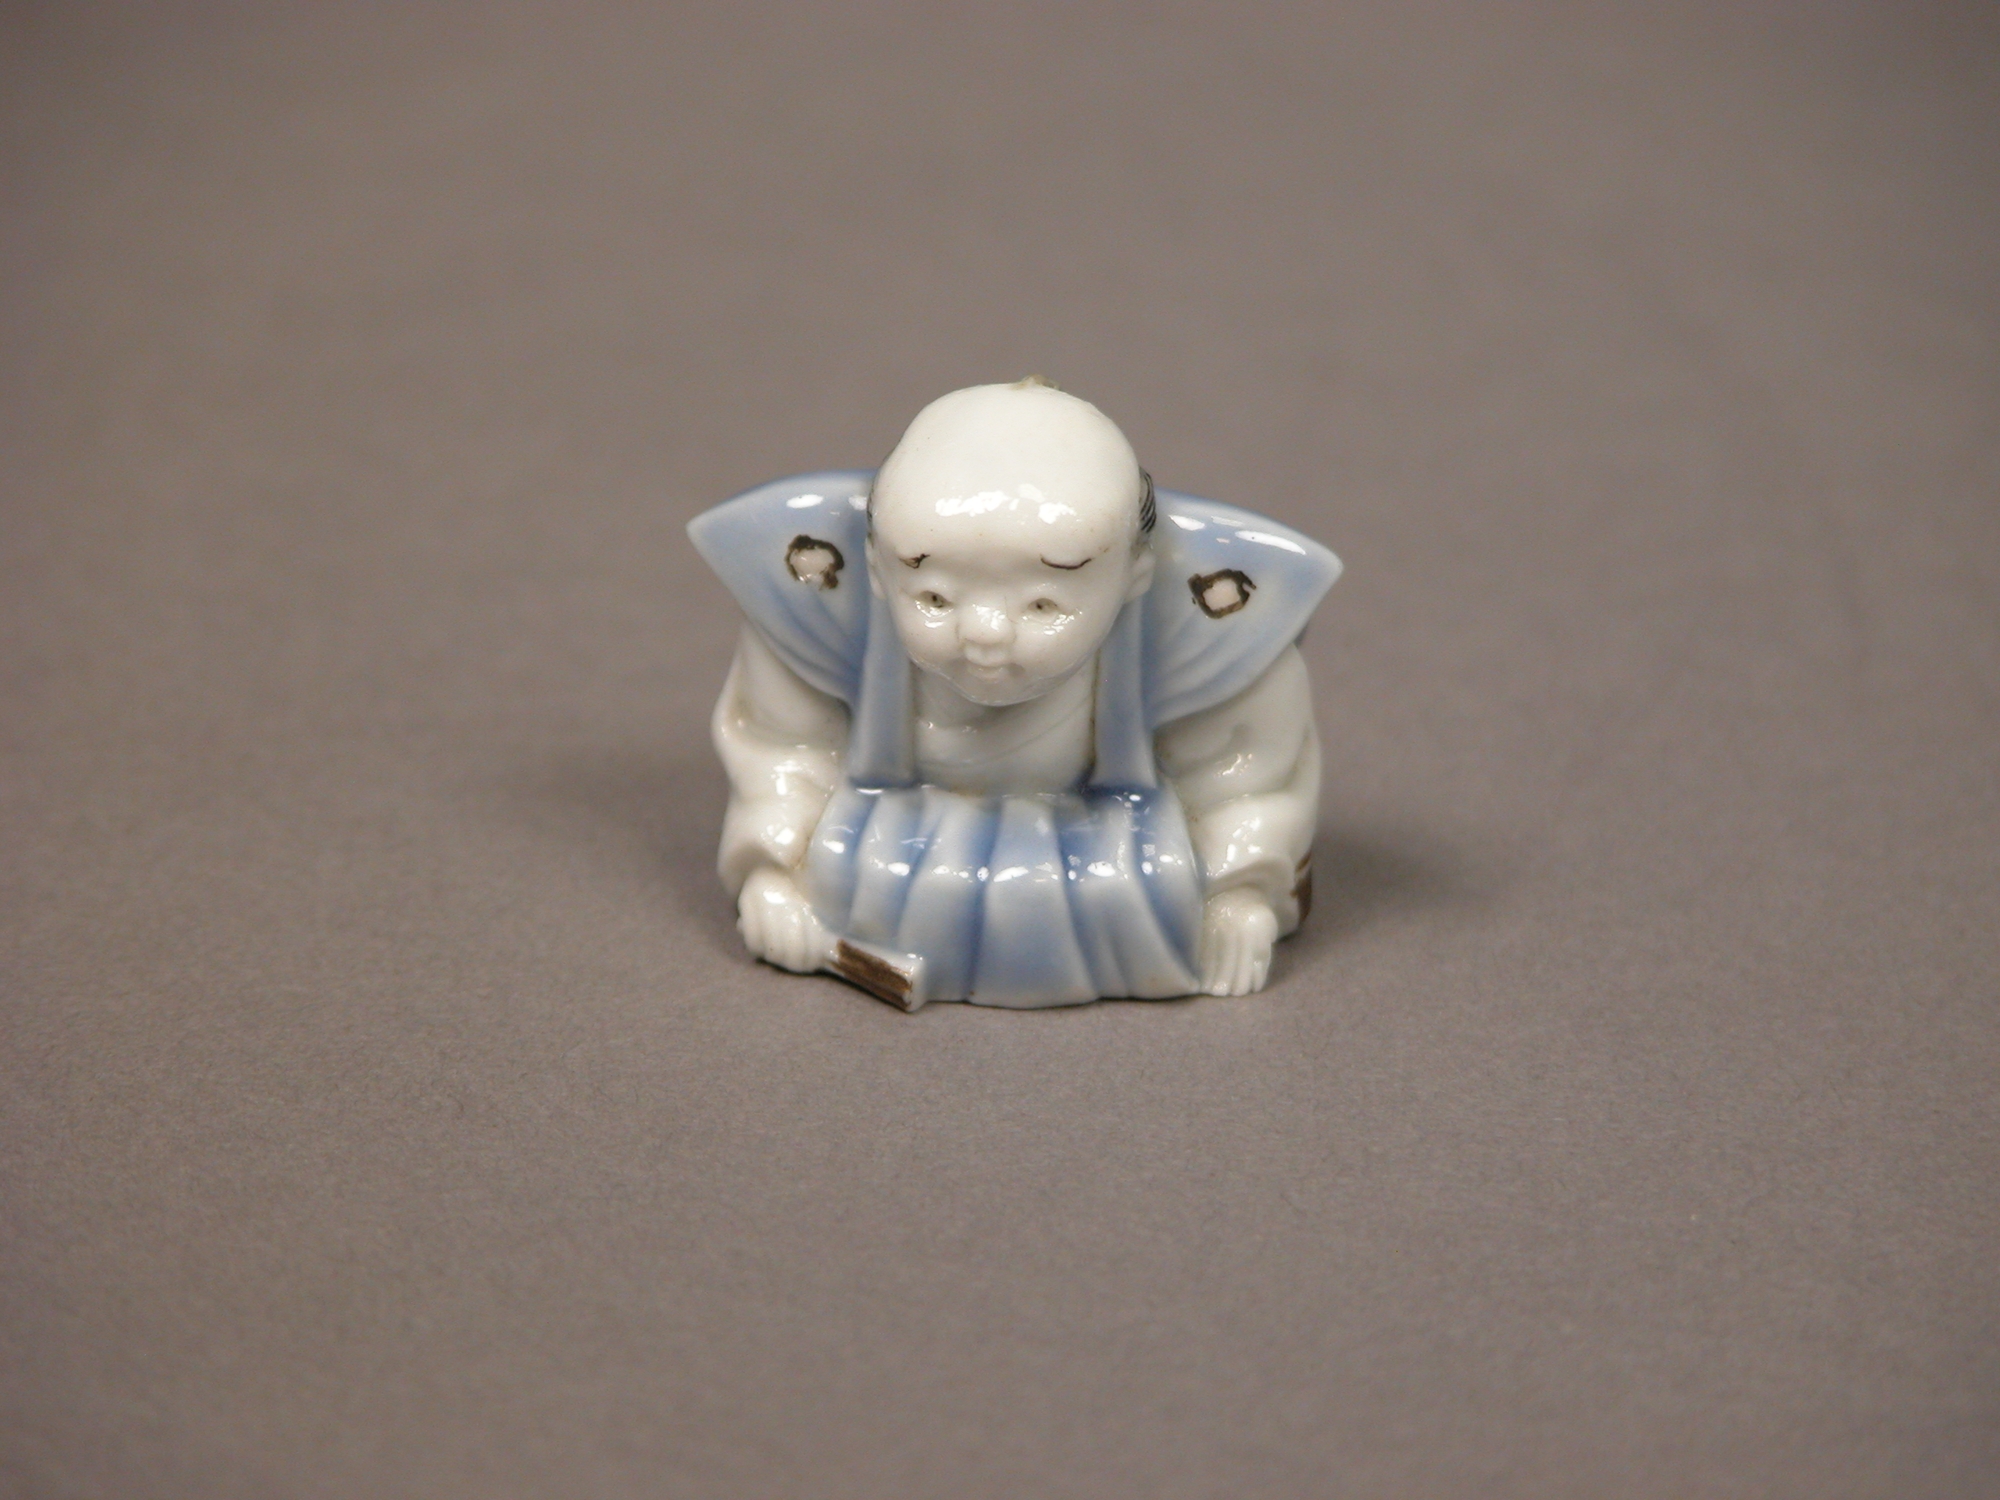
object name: figure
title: Chinese child with musical instrument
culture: japanese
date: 1767-1800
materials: iron, porcelain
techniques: underglaze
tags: musical instruments,boys